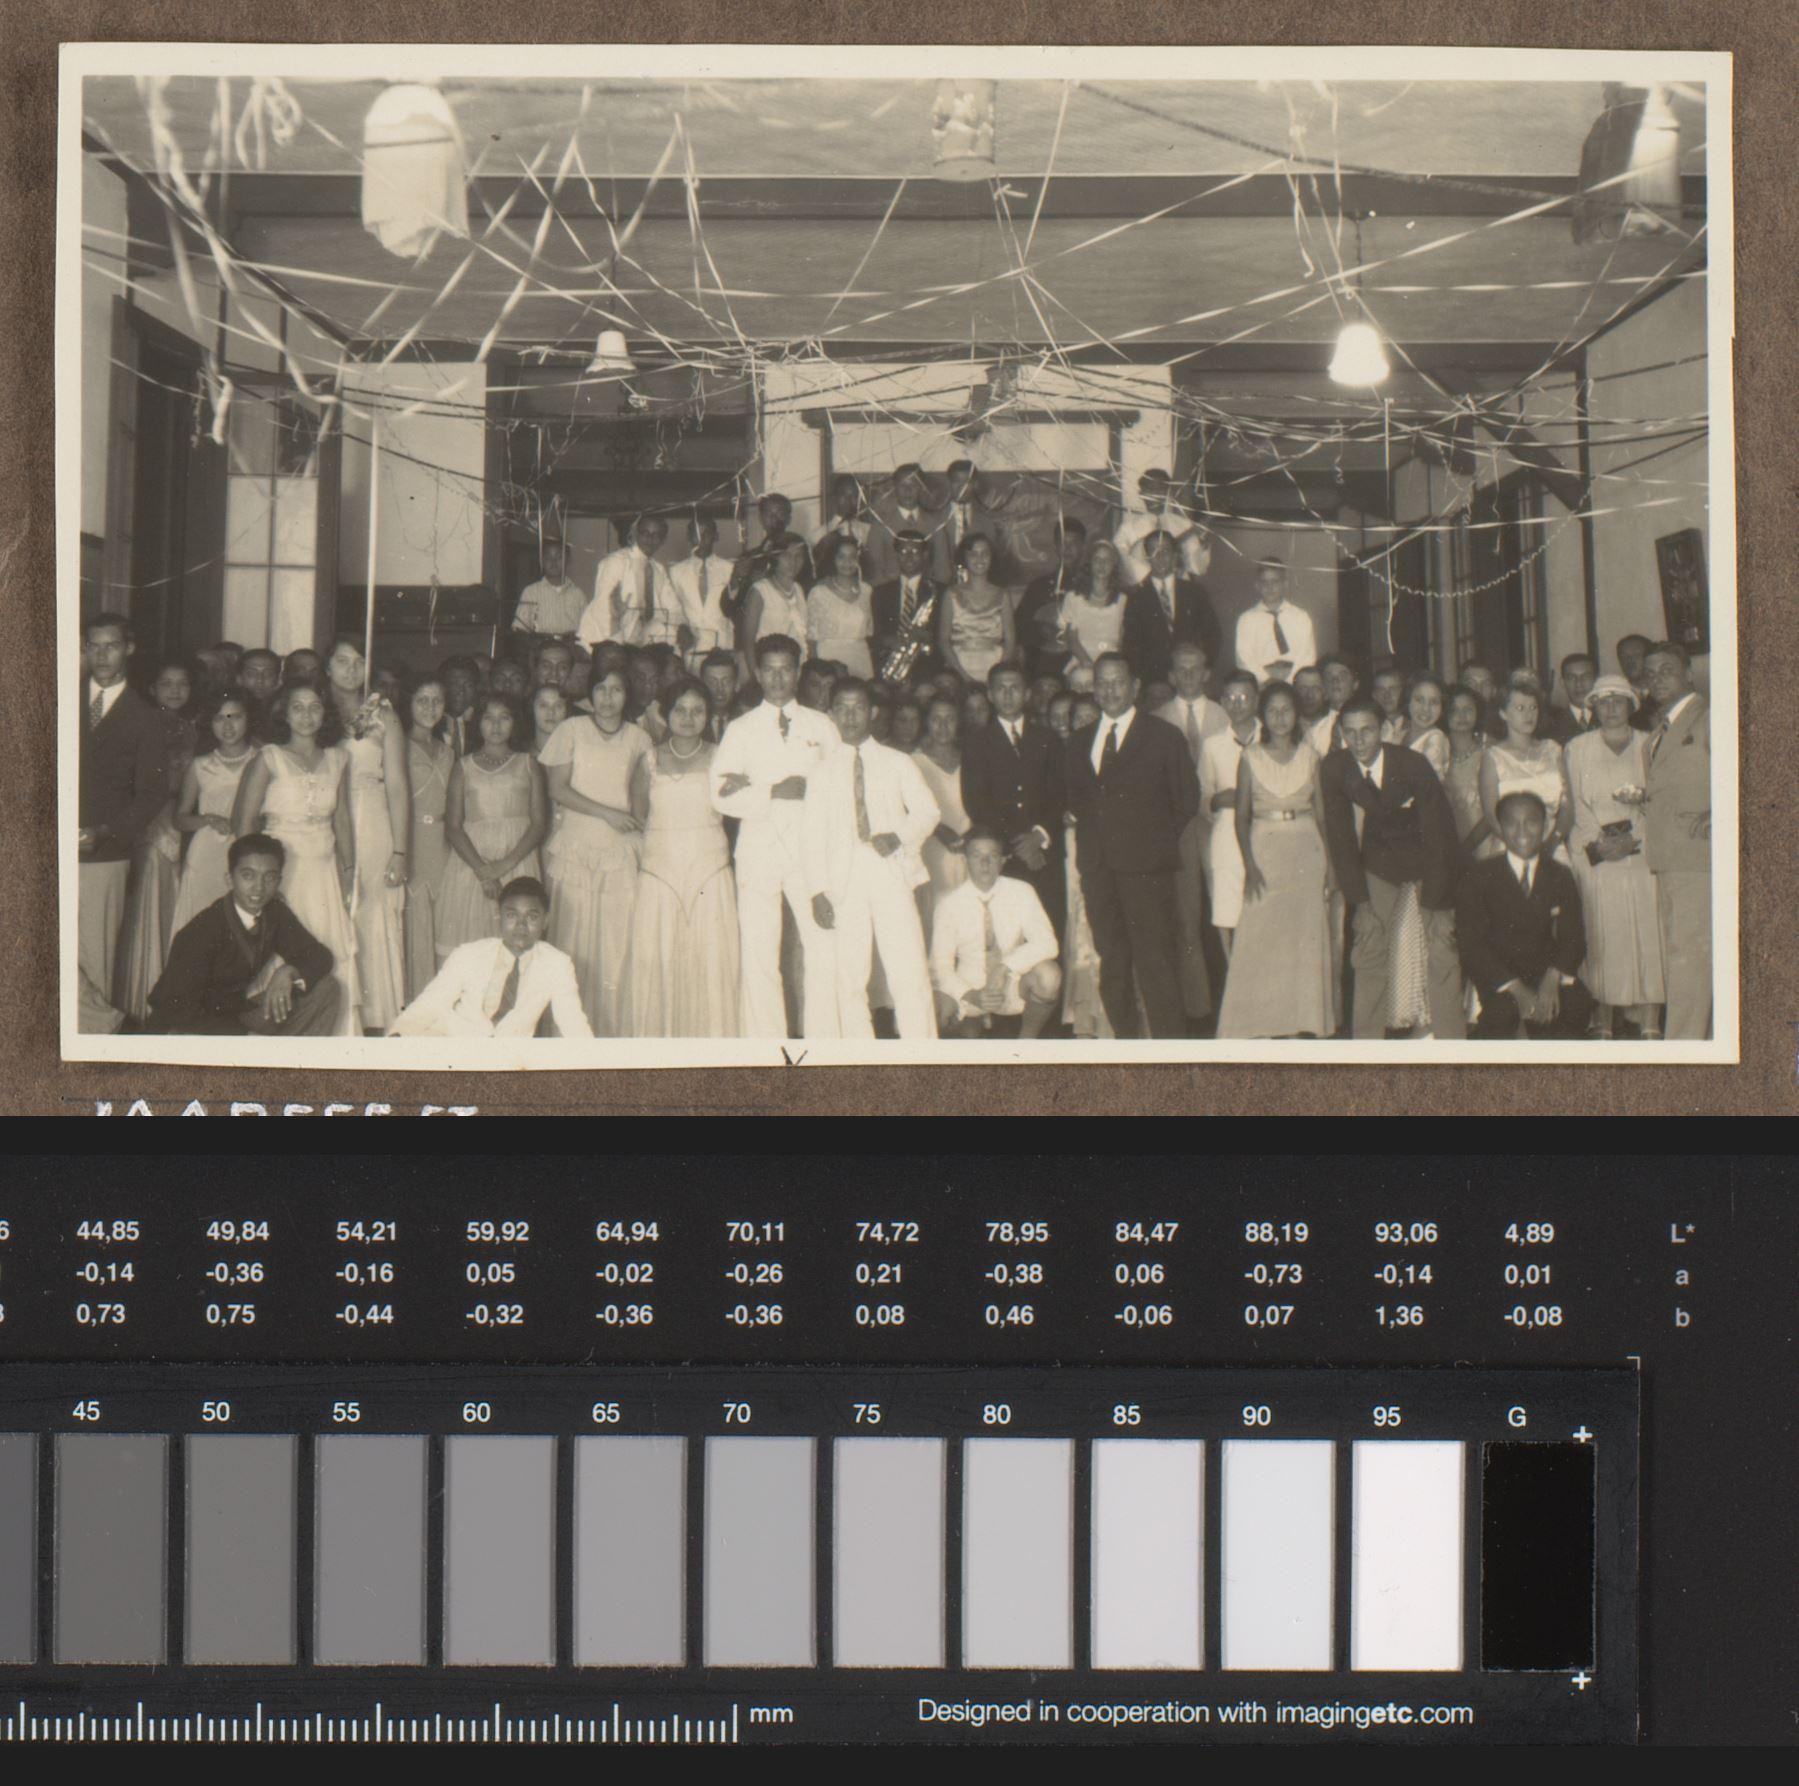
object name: photograph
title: Jaarfeest van de Technische School te Bandoeng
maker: Anonymous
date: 1933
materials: photographic support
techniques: gelatin silver print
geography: bandung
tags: vocational education, e.g.: junior technical school, colonial government, dutch east indies, the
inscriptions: inscription: ‘Jaarfeest. / Einde. / TS’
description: Jaarfeest van de Technische School te Bandoeng. Groepsfoto in de met slingers versierde feestzaal van de leerlingen met introducés en docenten. Foto ingeplakt in het fotoalbum aangeboden aan J.H.A. van der Hoeven bij het beëindigen op 31 juli 1933 van zijn diensttijd bij het Nijverheidsonderwijs in Nederlandsch-Indië.